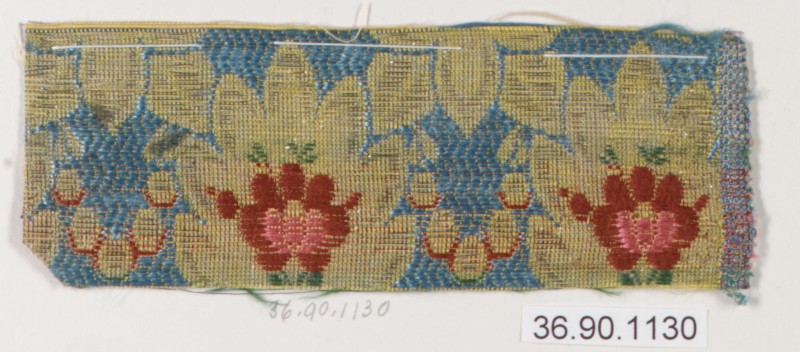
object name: sample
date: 1701-1900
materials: metal thread, silk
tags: flowers